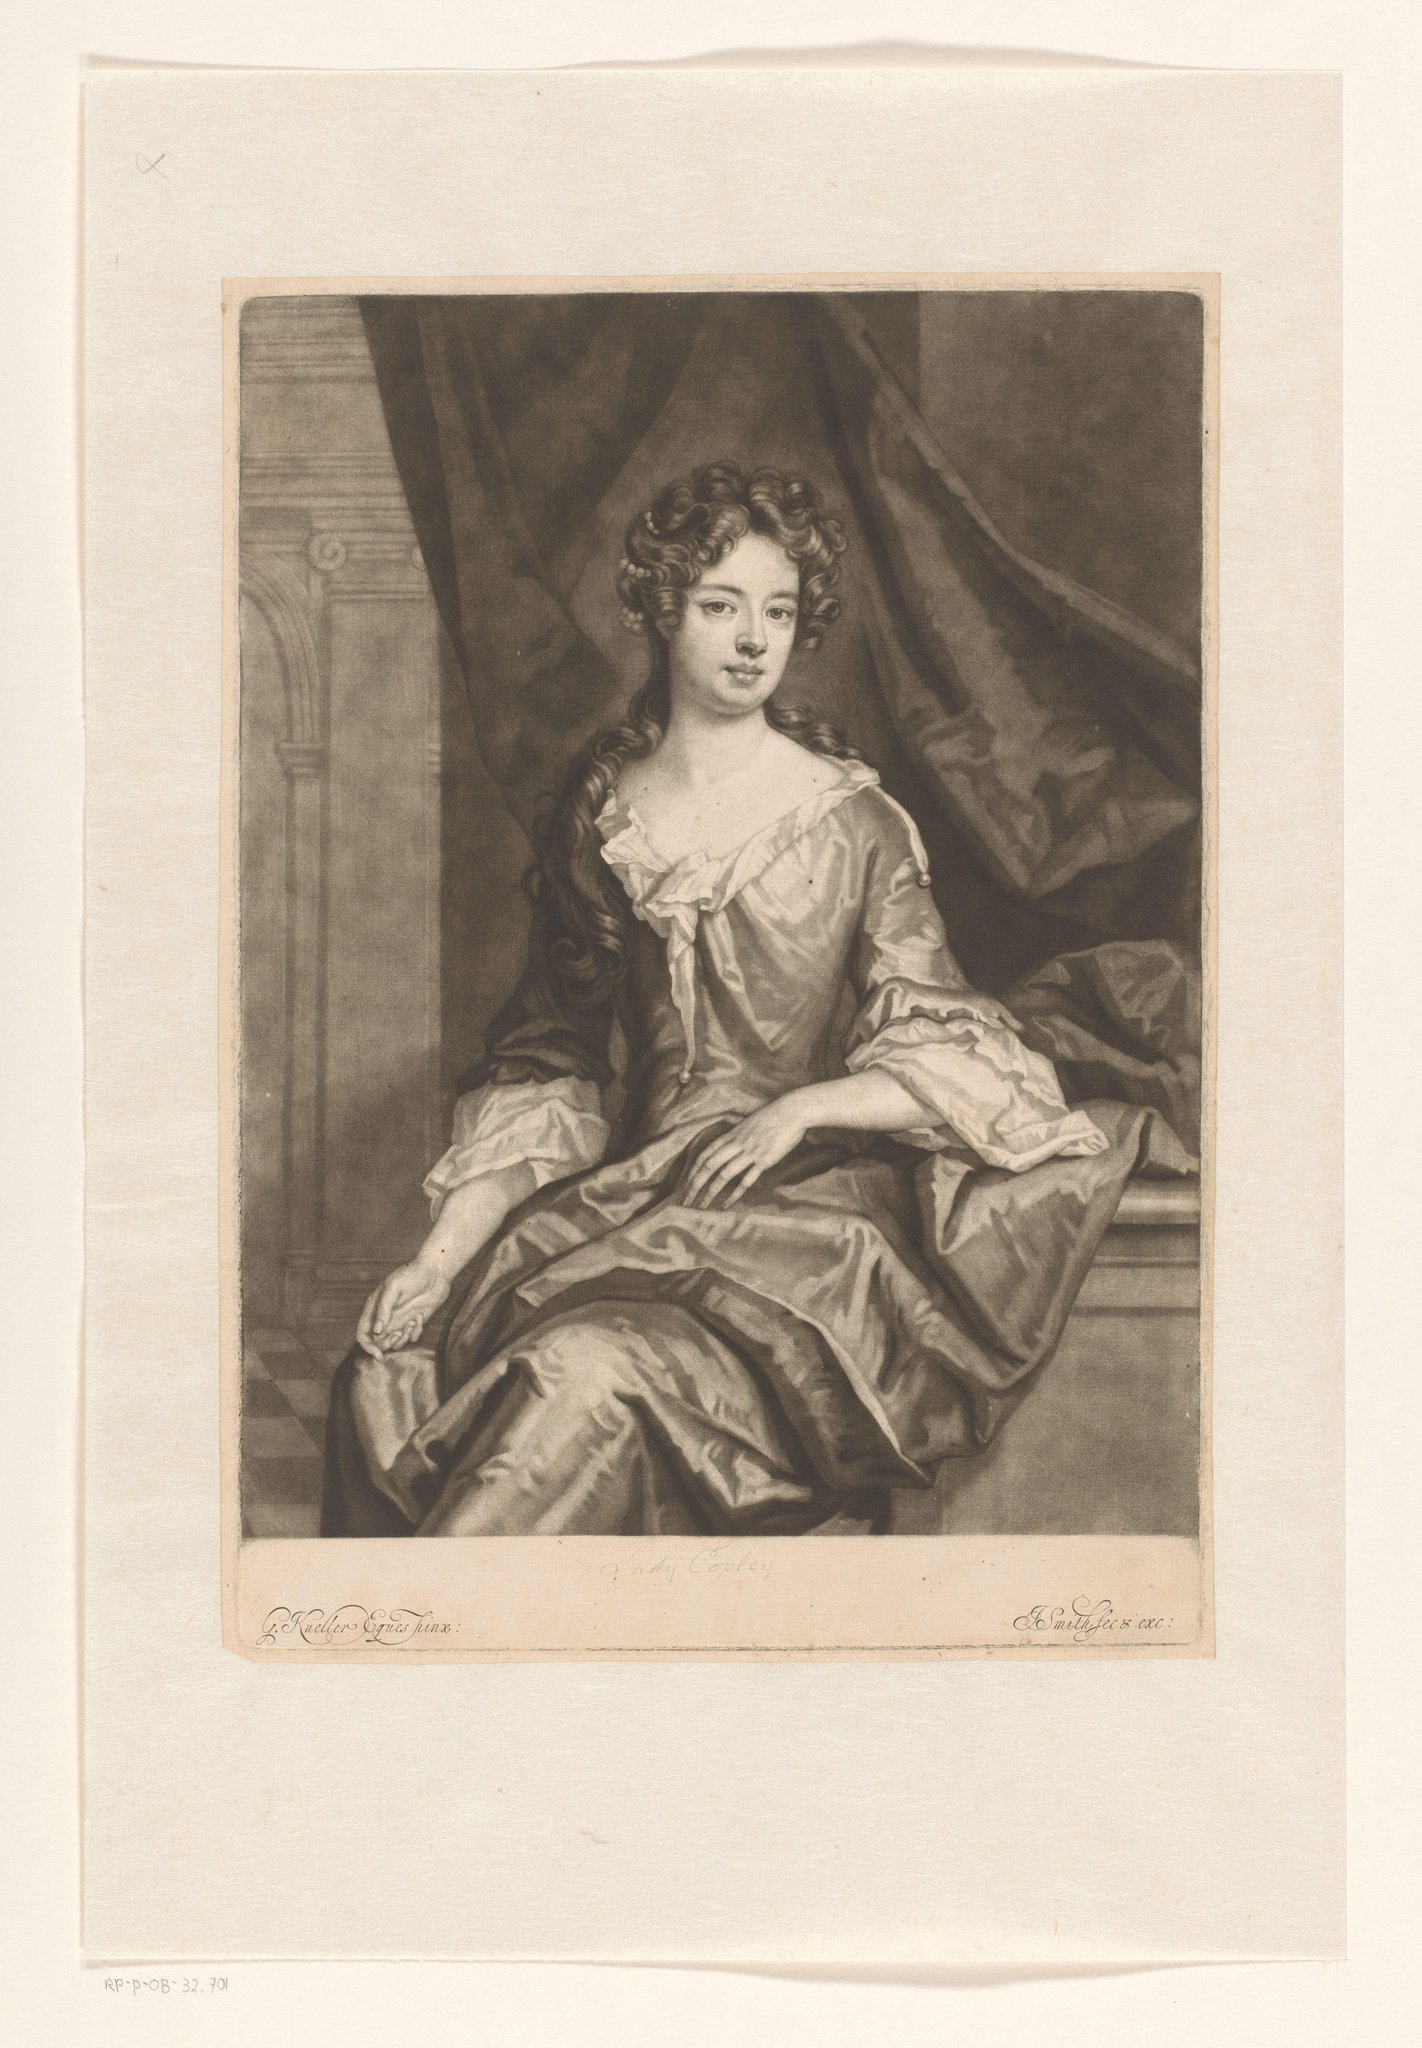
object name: print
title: The Lady Copley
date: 1662-1742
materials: paper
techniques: mezzotint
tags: historical persons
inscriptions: annotation: ‘The Lady Copley’, collector's mark: Lugt 240